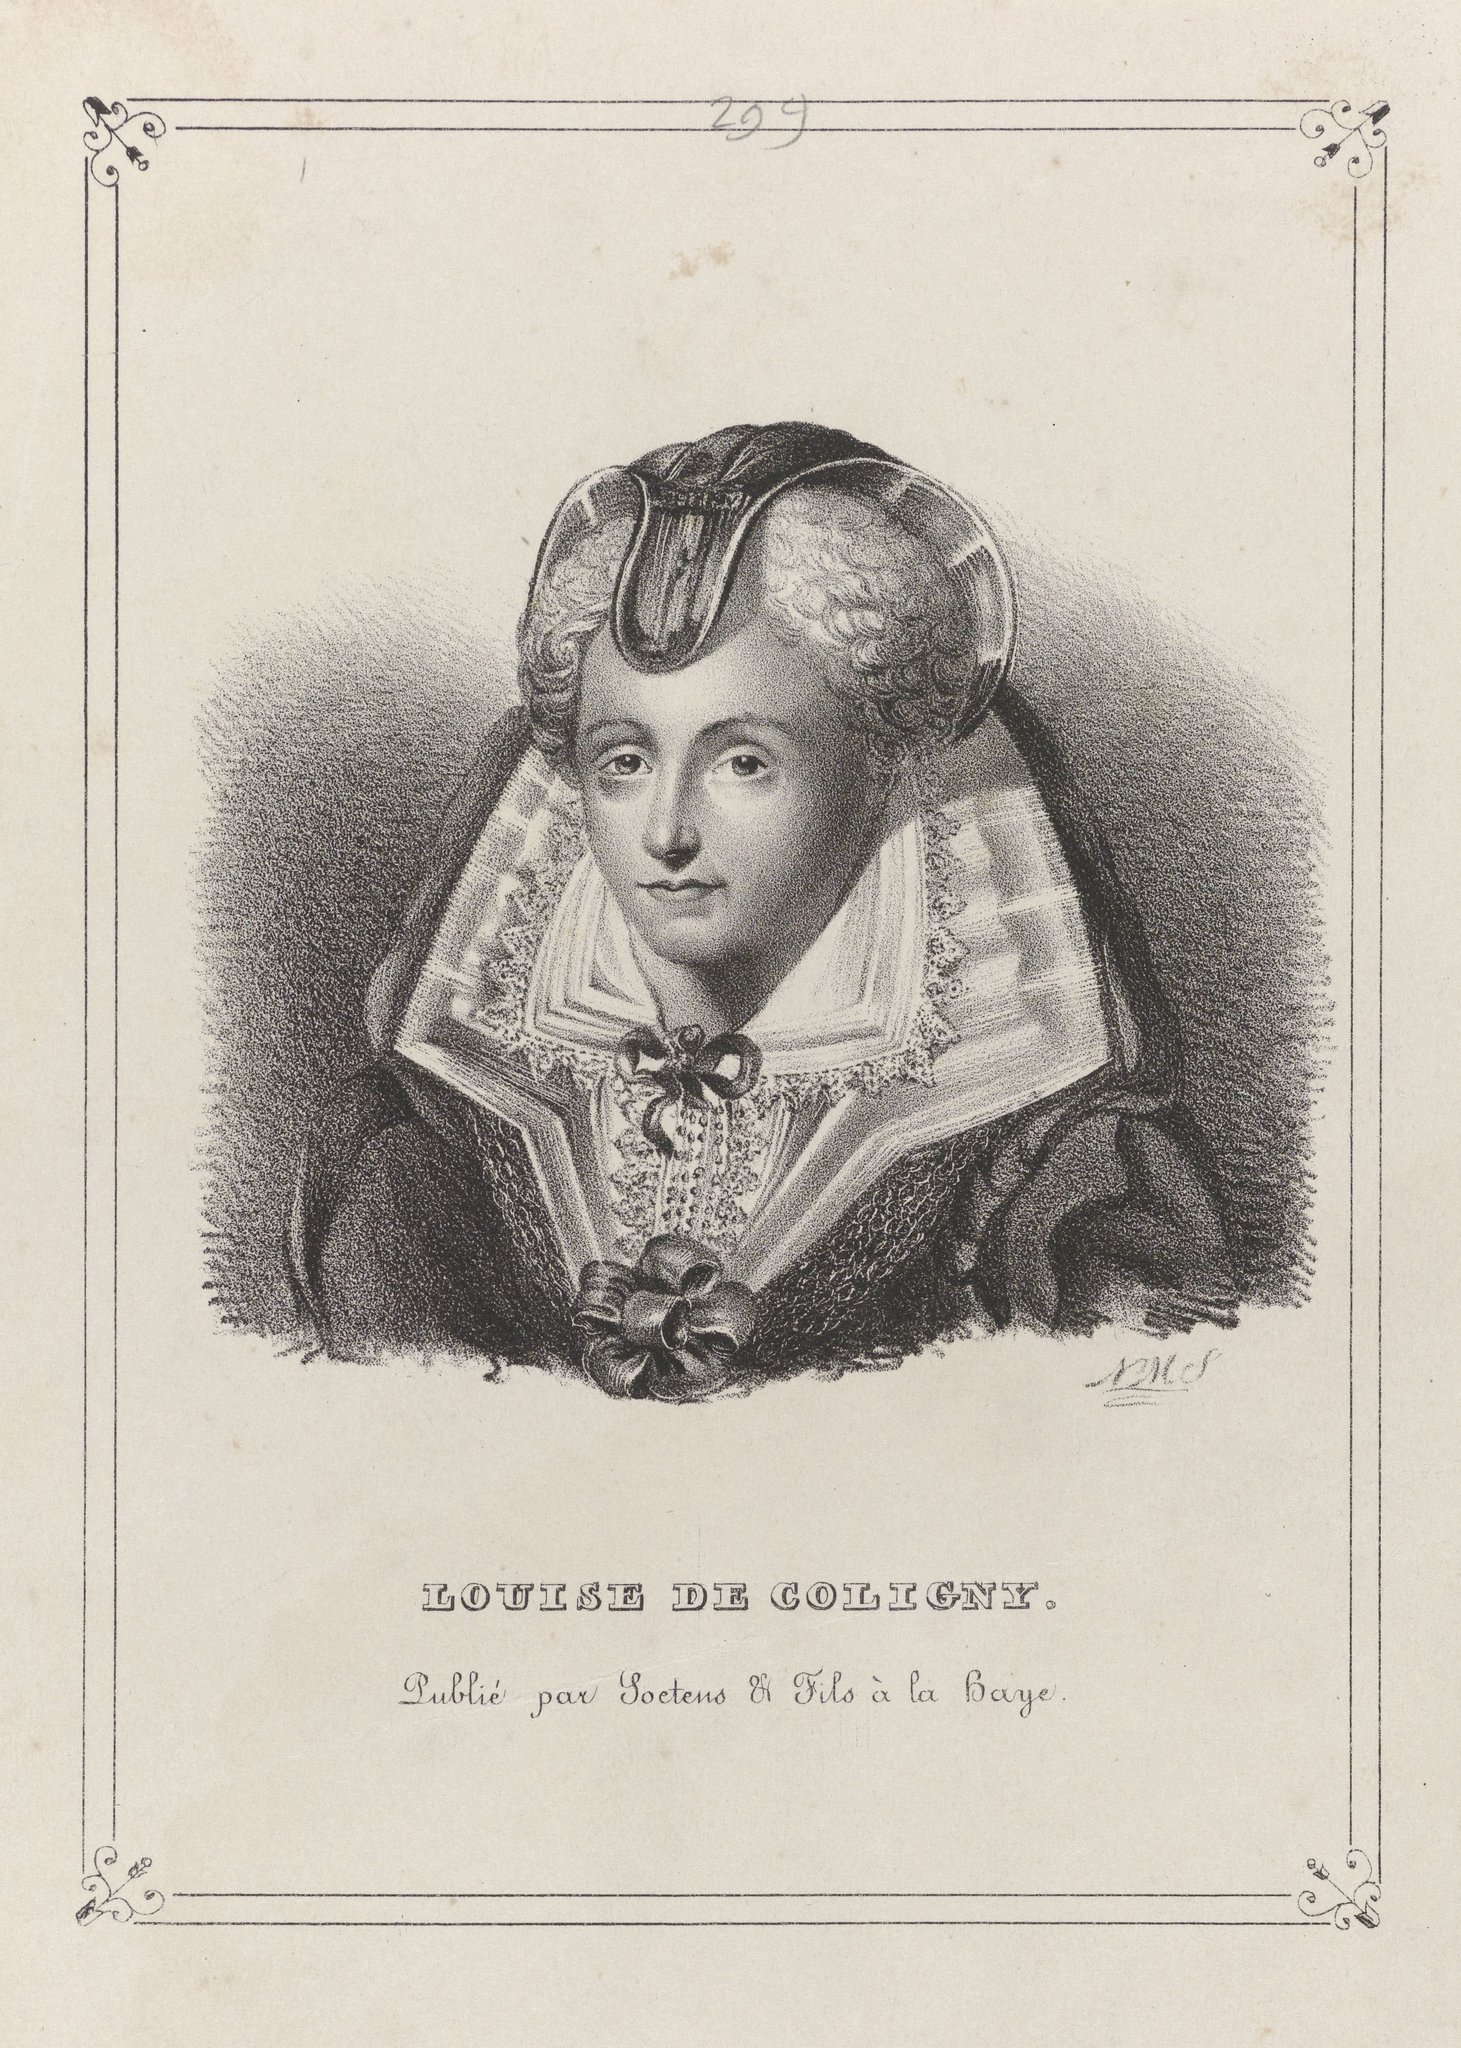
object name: print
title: Portret van Louise de Coligny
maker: nicolaas martinus schild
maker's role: draughtsman, print maker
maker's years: 1822-1840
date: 1837-1840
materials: paper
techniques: lithograph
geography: netherlands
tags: louise de coligny, neck-gear: collar (+ women's clothes)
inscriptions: collector's mark: Lugt 2228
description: Portret van Louise in een geornamenteerde rechthoek. In de ondermarge haar naam.